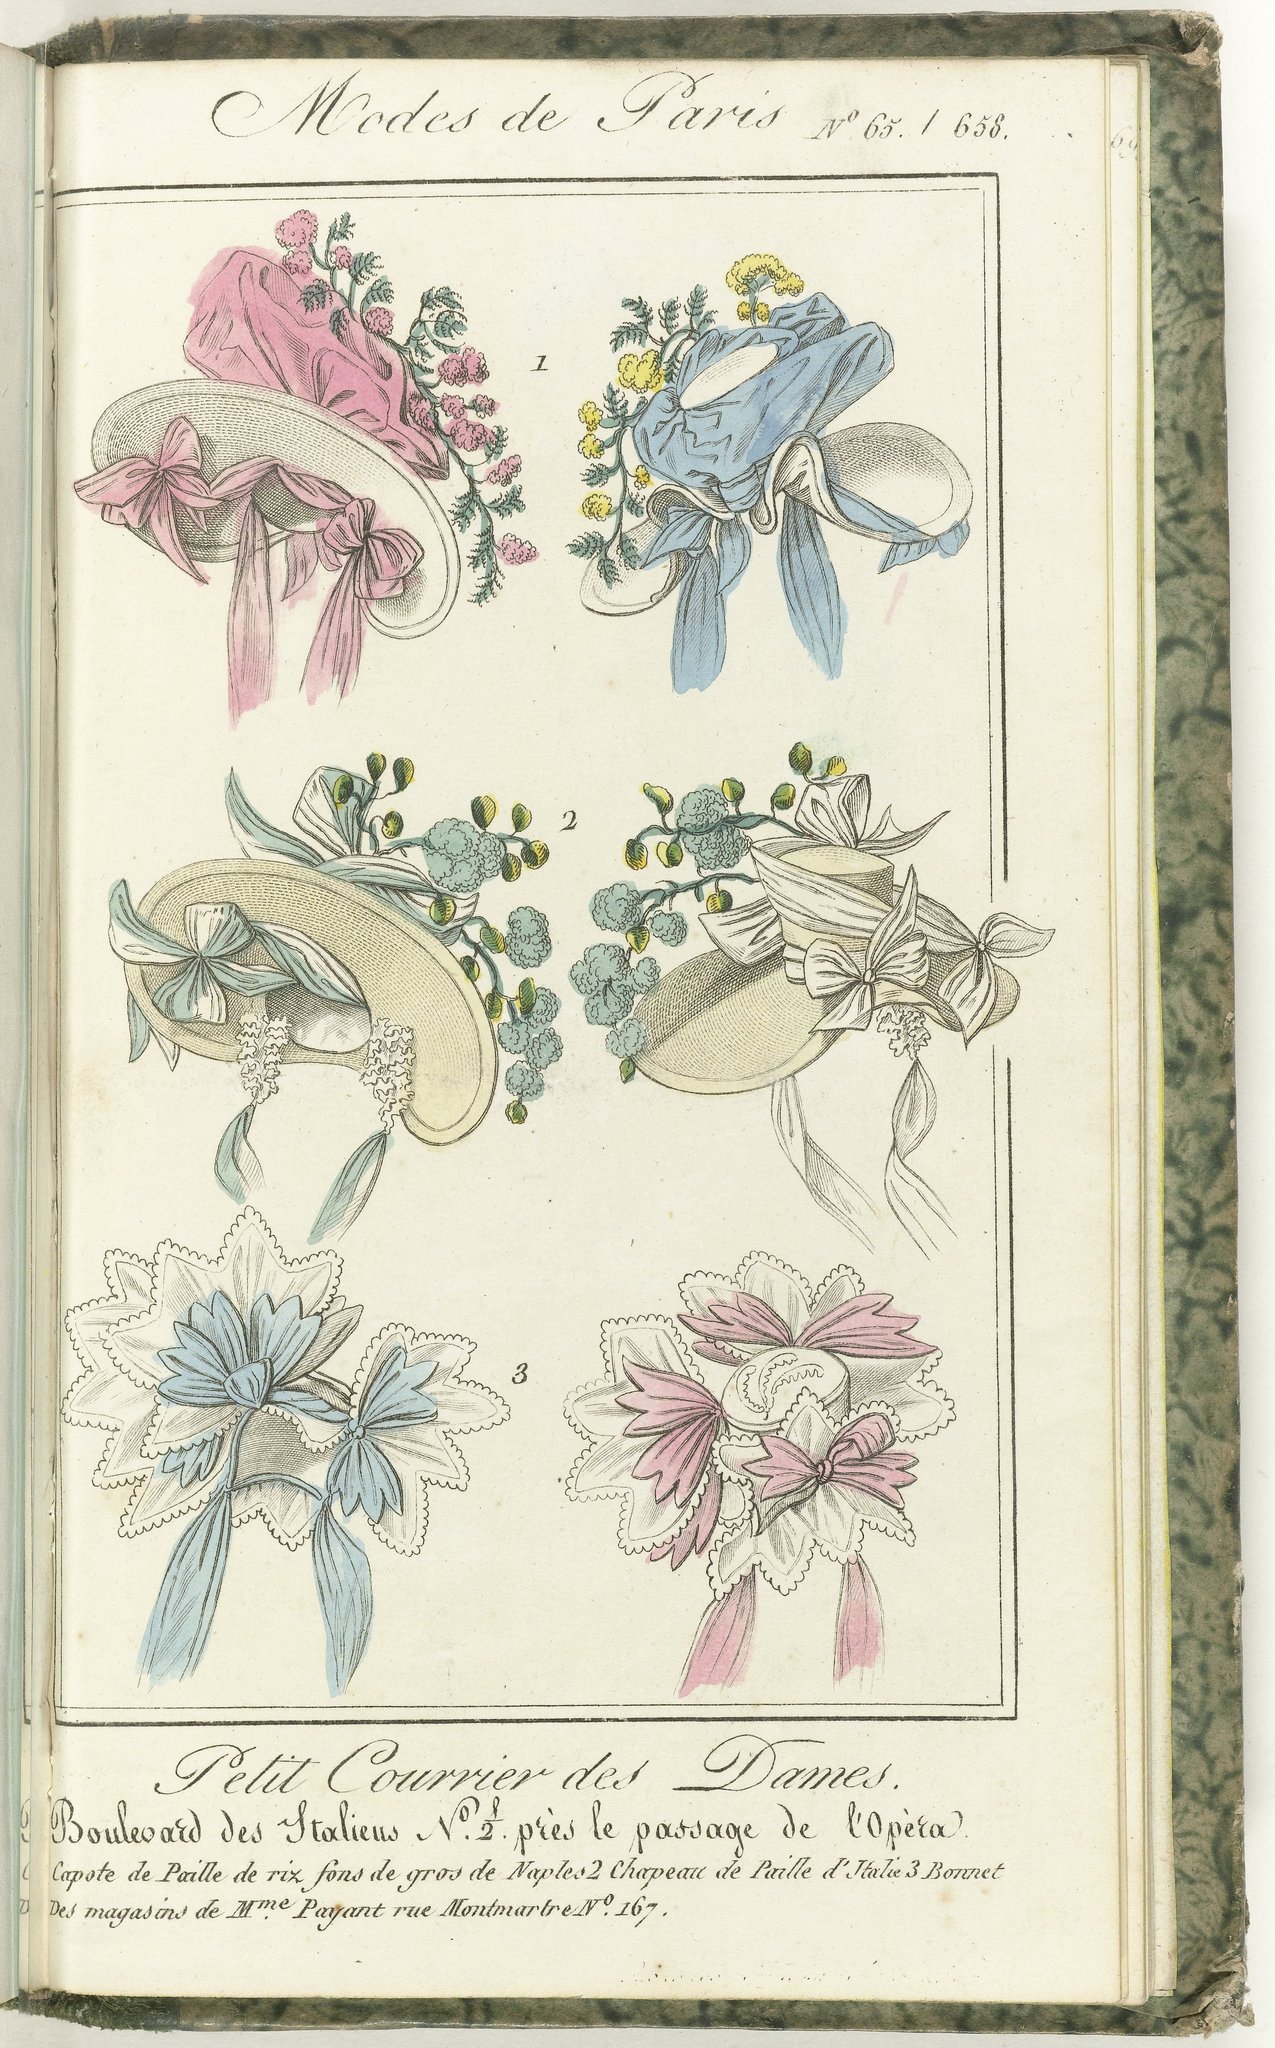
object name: fashion print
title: Petit Courrier des Dames, 10 août 1829, No.65 / 658 : Capote de Paille de riz...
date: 1829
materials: paper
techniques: engraving, hand coloring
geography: paris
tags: head-gear (capote) (+ women's clothes), head-gear: cap (+ women's clothes), fashion plates, head-gear: hat (+ women's clothes)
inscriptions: title: ‘Petit Courrier des Dames.’, address: ‘Boulevard des Italiens No.2 près le passage de l'Opèra.’, title: ‘Modes de Paris.’, caption: ‘Capote de paille de riz, fons de gros de Naples 2 Chapeau de Paille d'Italie 3 Bonnet Des magasins de M.me Payant rue Montmartre No. 167.’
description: Drie verschillende hoofddeksels, van de voor- en achterzijde weergeven, genummerd één tot en met drie. 1. Capote van 'paille de riz' en 'gros de Naples'. 2. Hoed van 'paille d'Italie' 3. Muts, uit de winkels van Payant.Prent uit het modetijdschrift Petit Courrier des Dames (1821-1868). Ingebonden (met enkele pag. Le Journal des Dames et des Modes). 15 Januari 1827 t/m 20 maart 1830. Incompleet.